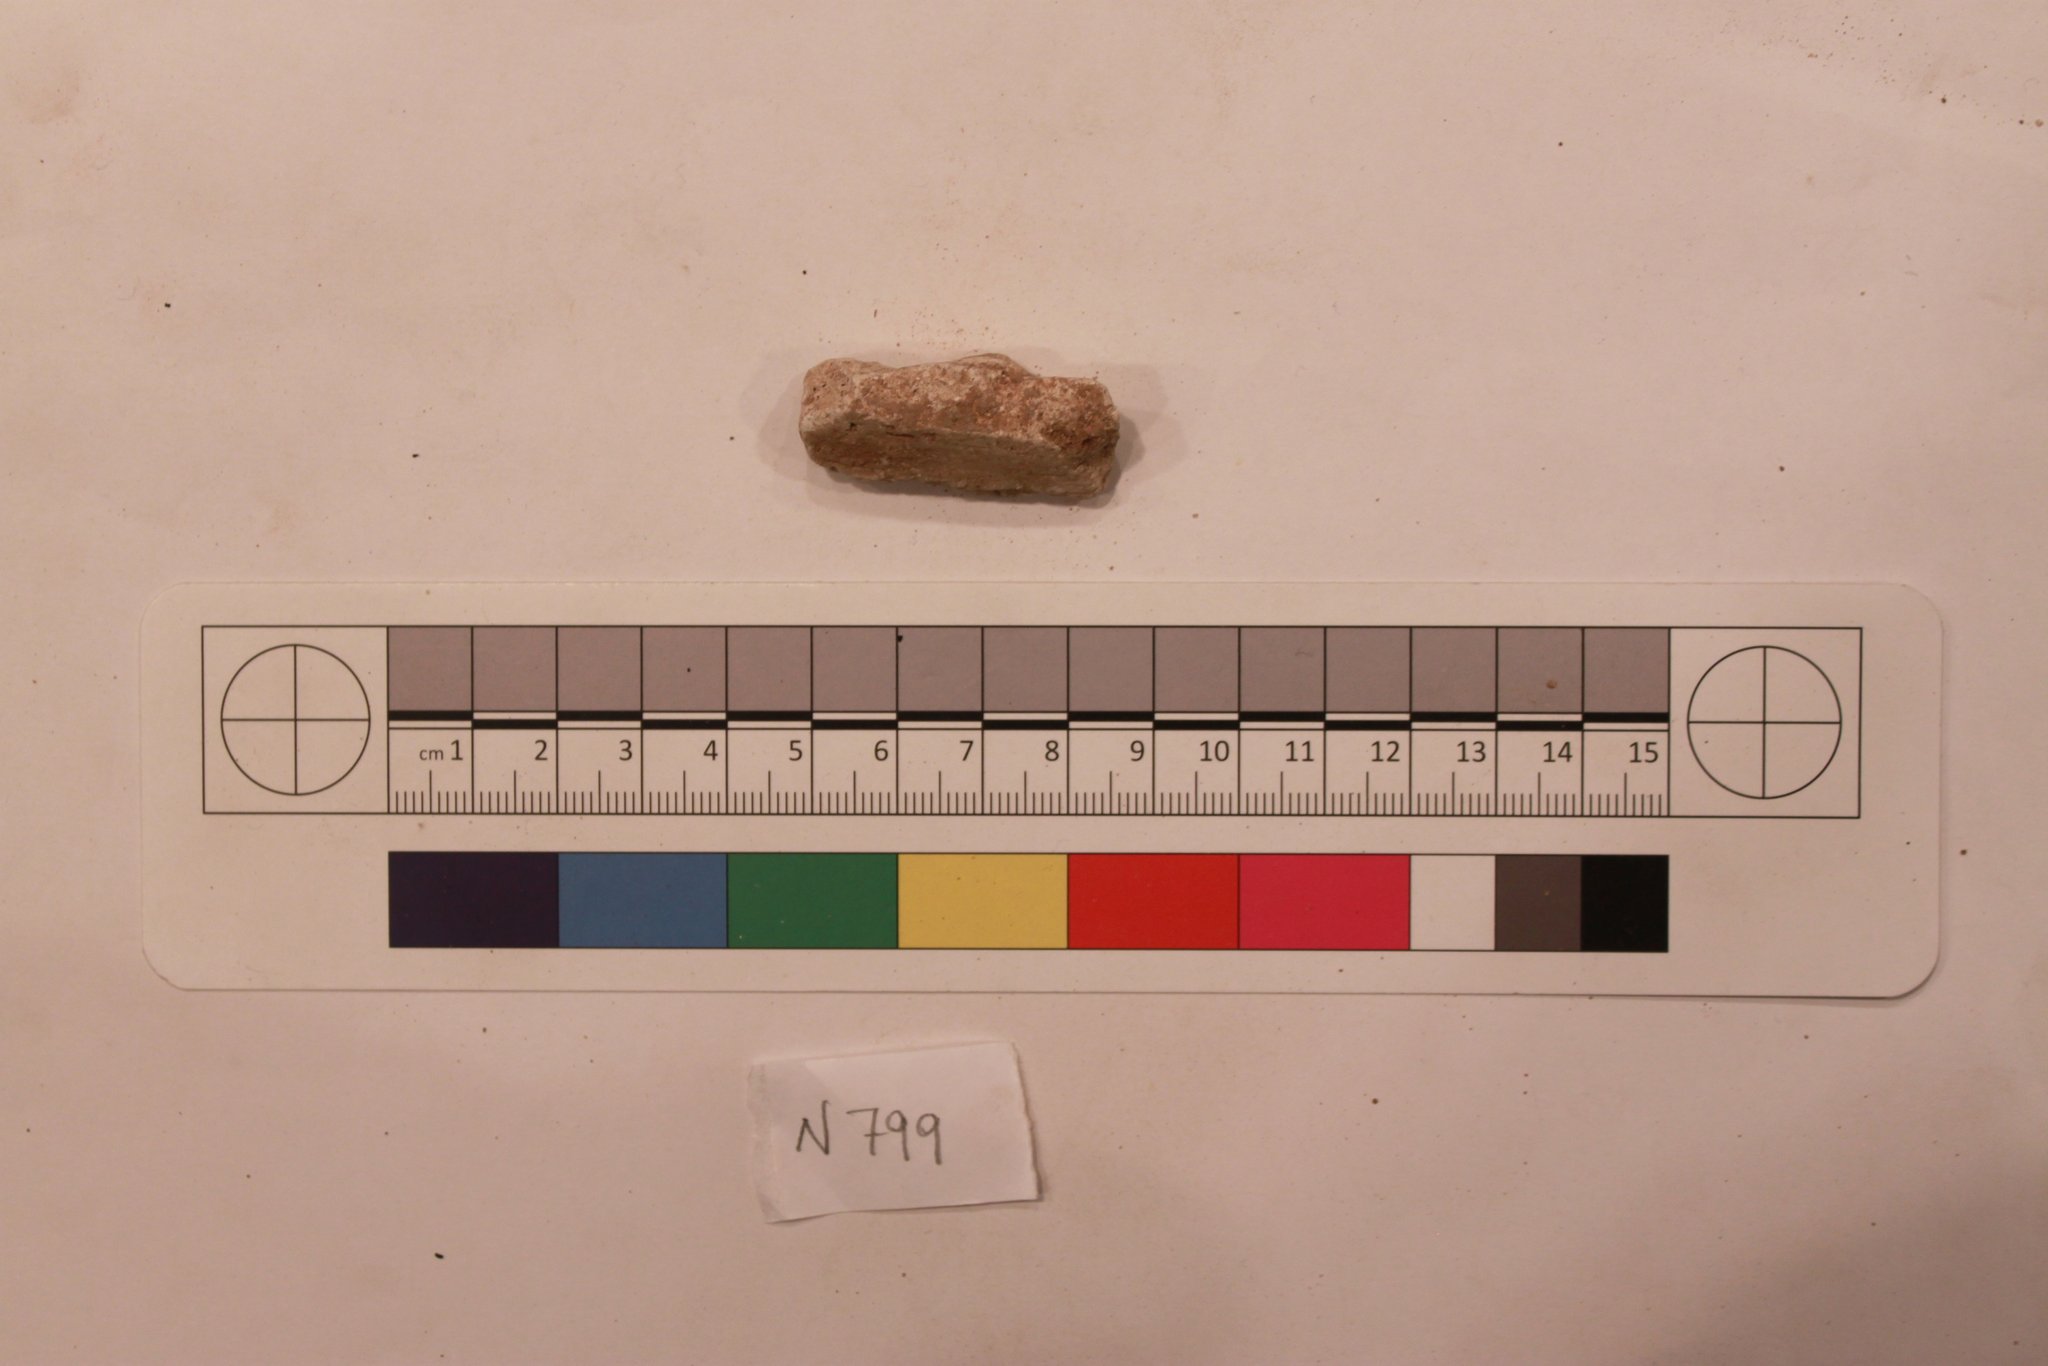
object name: fragment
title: Stucco Fragment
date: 701-1200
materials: plaster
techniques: carving, painting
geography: iran